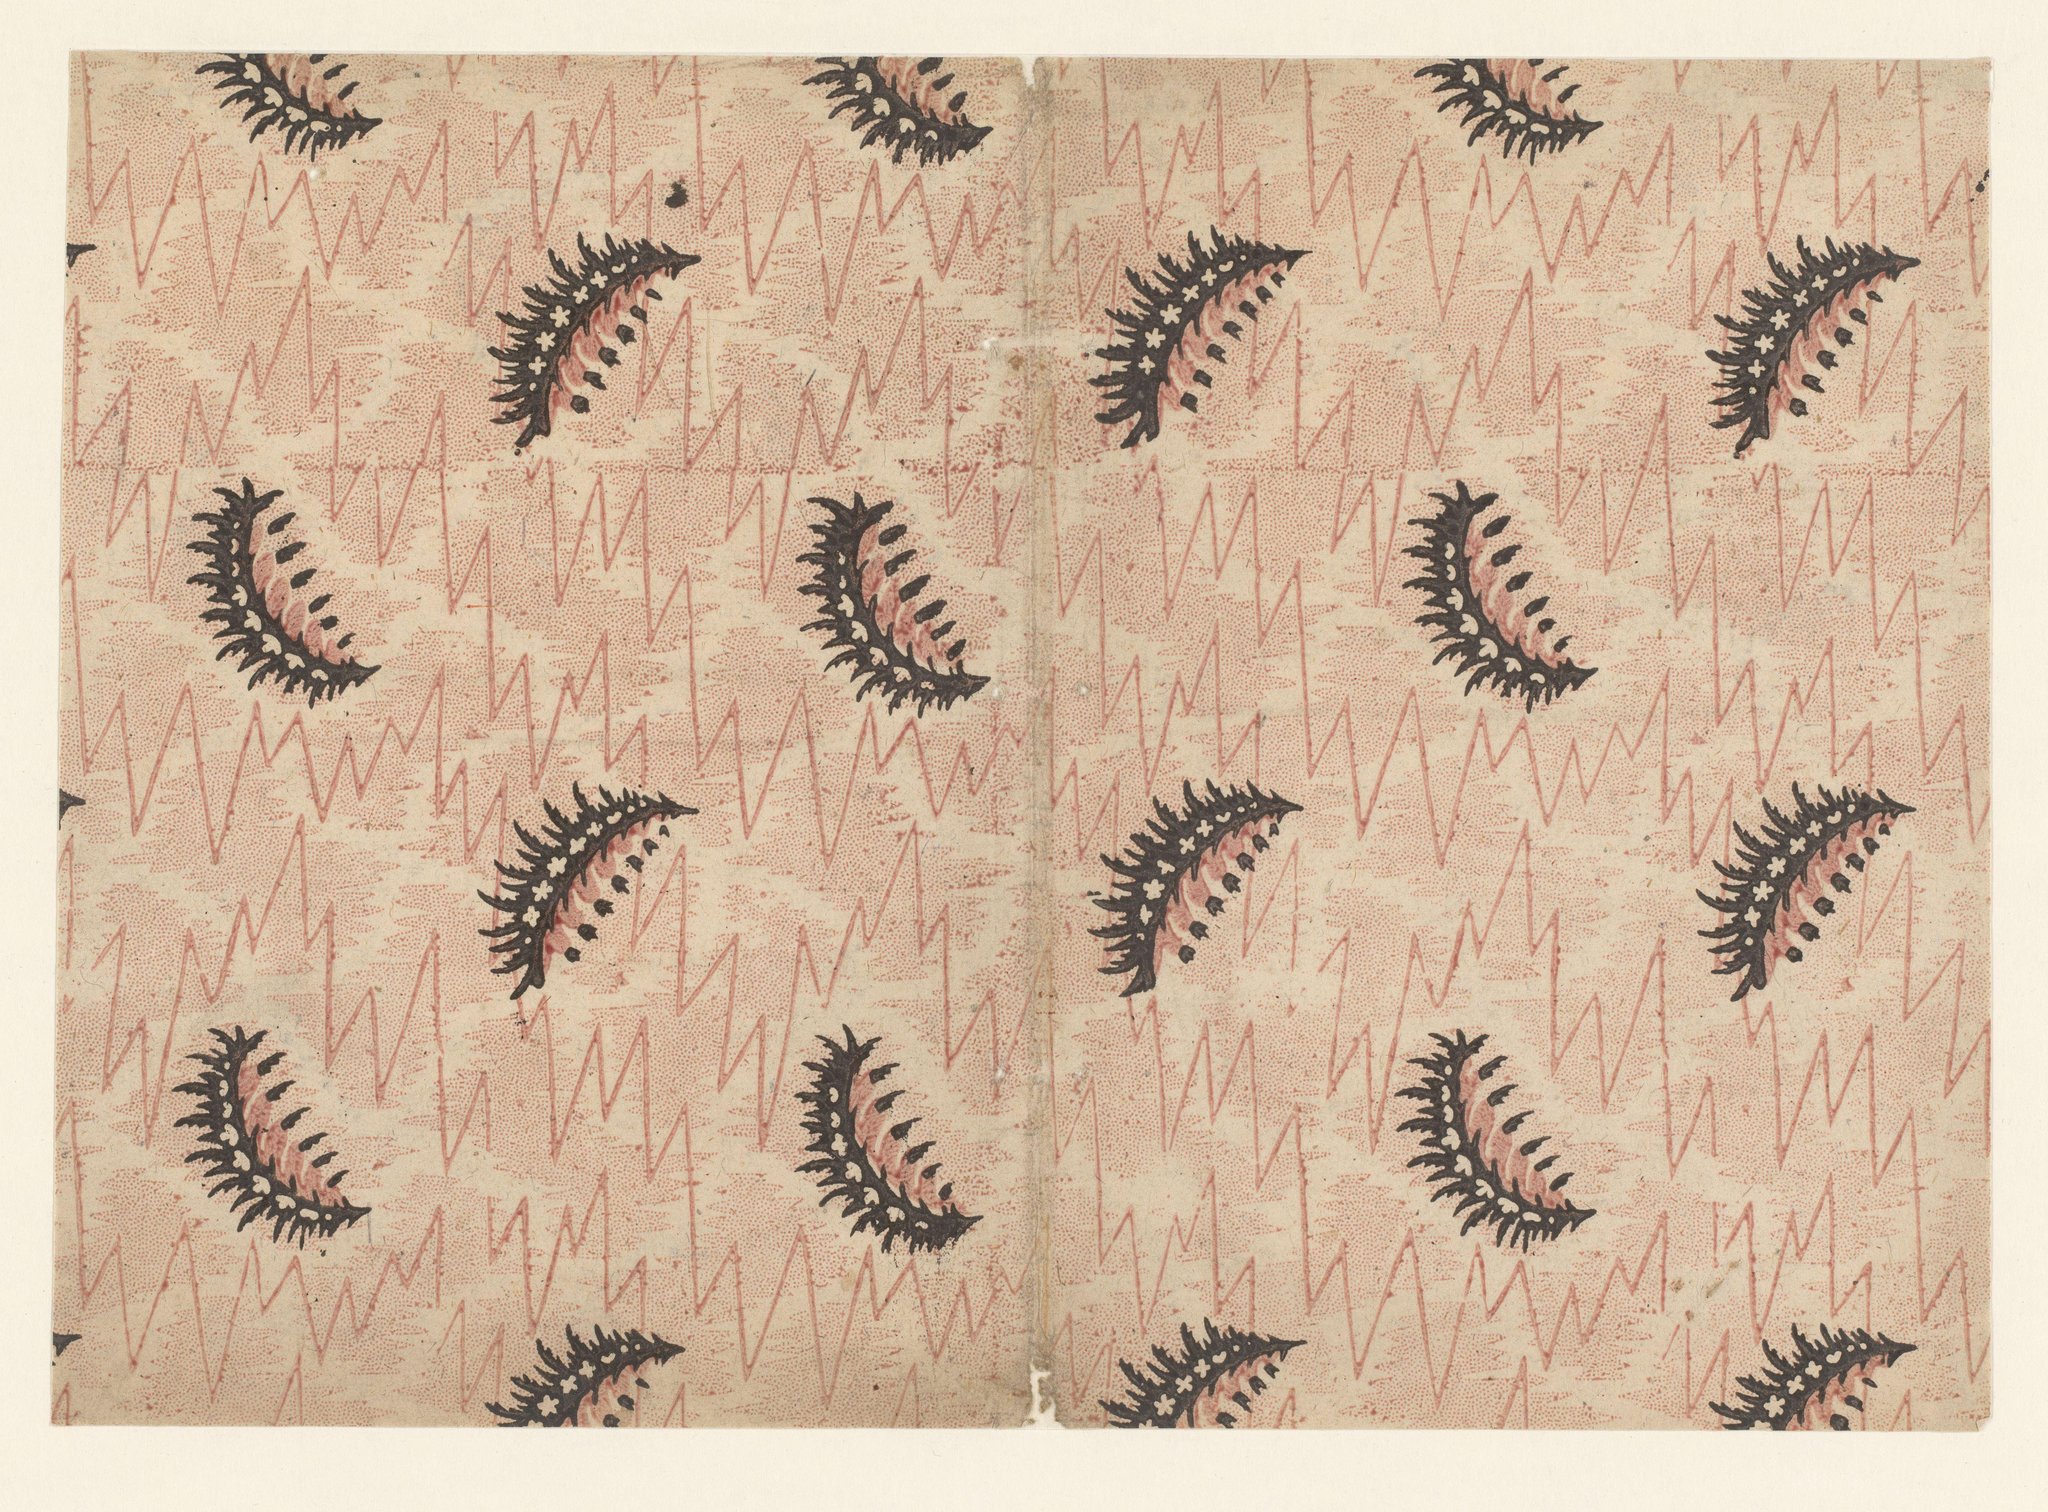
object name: wrapper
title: Blad met rupsachtig motief op punten- en zigzaglijnenfond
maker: Anonymous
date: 1700-1850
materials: paper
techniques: printing block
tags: fantasy ornament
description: Blad met fantasie-, rupsachtig motief op een punten- en zigzaglijnenfond. Gebruikt als omslag.